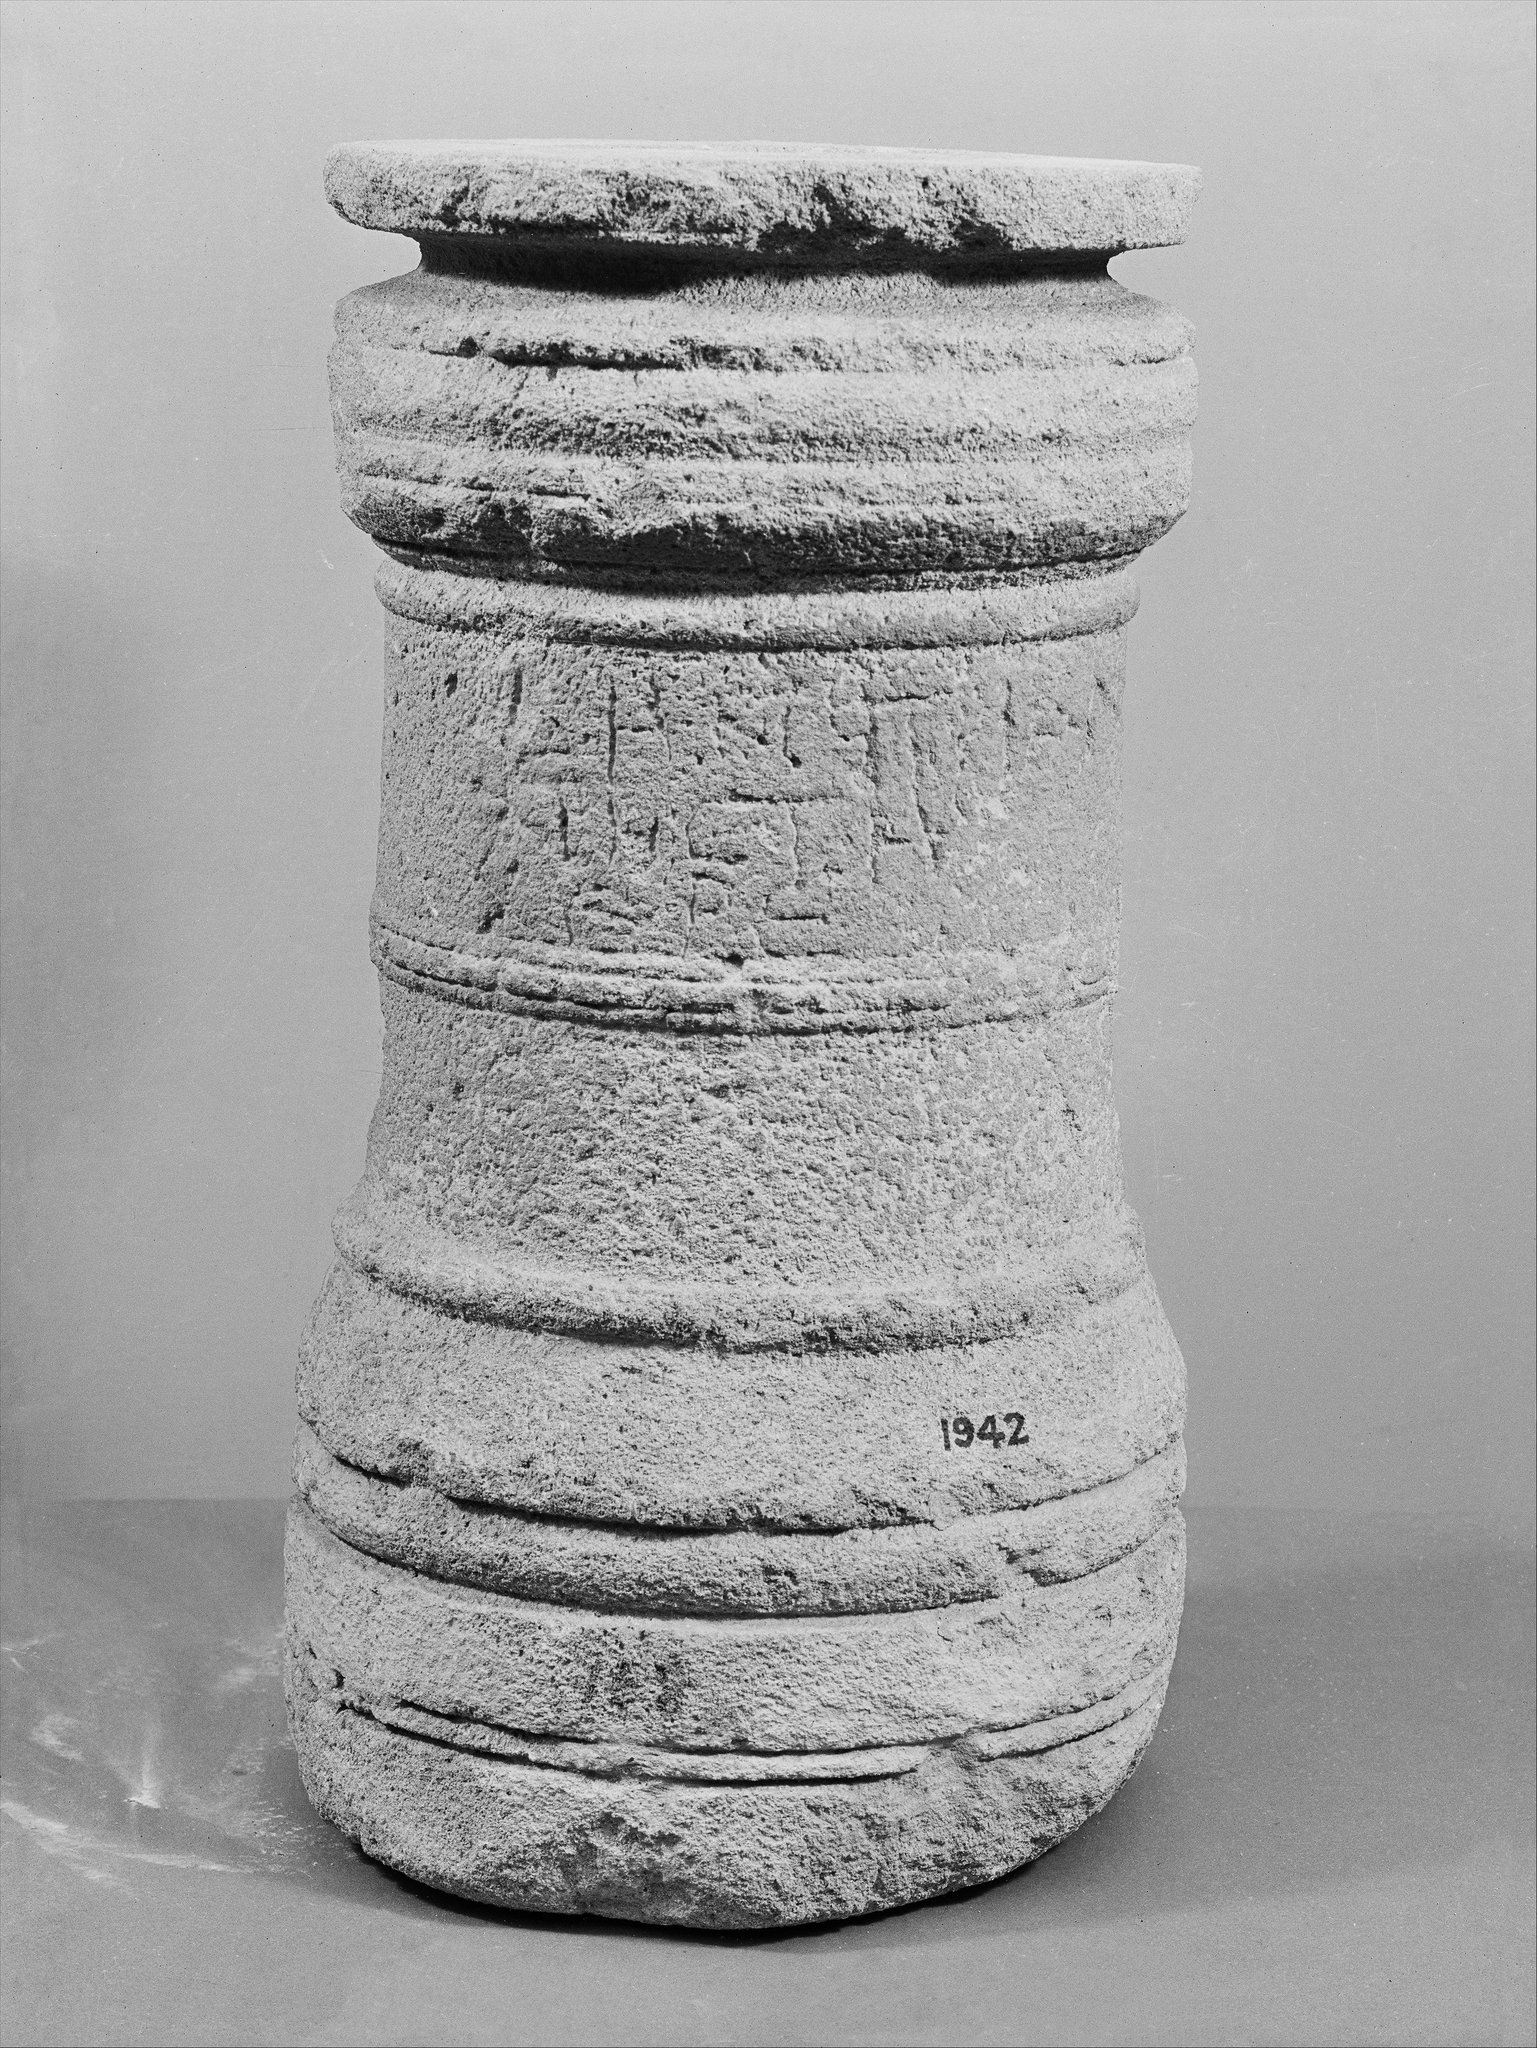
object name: cippus of onesimos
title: Limestone cippus of Onesimos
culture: roman, cypriot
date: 101-300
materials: limestone